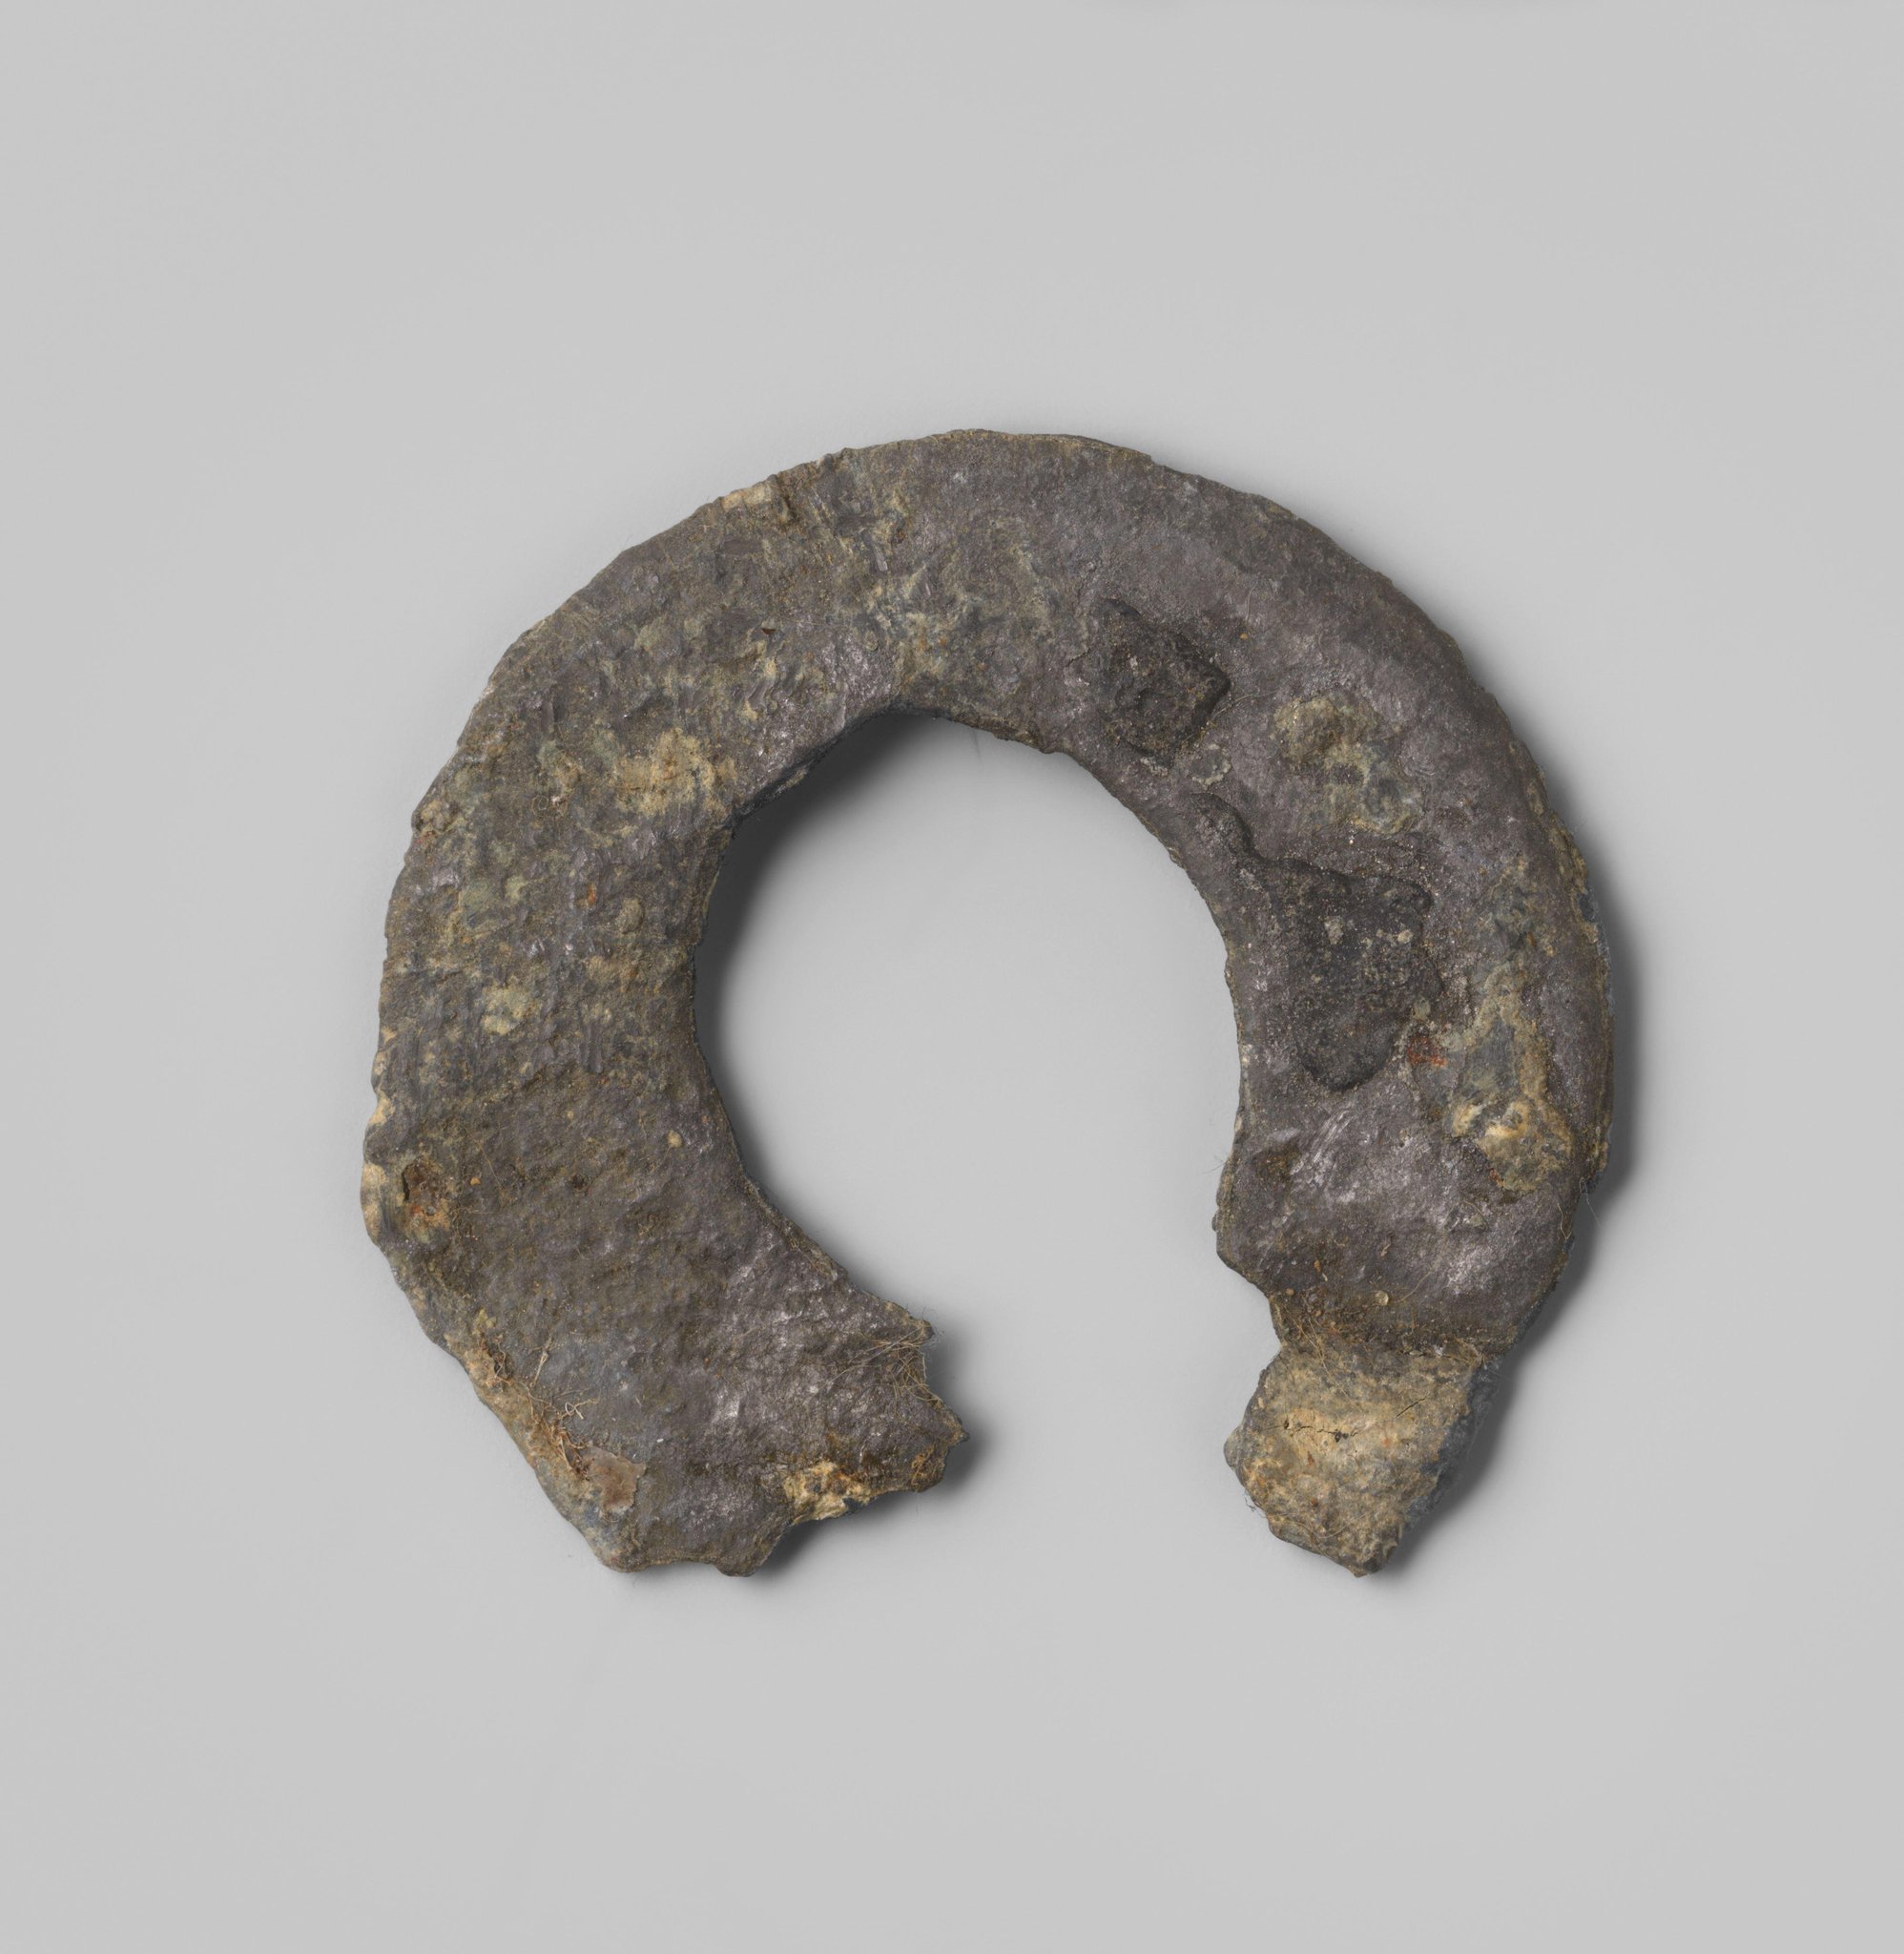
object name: lakenloodje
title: Fragment lakenloodje uit het wrak van de Oost-Indiëvaarder Hollandia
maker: Anonymous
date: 1700-1743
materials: lead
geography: netherlands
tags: verenigde oostindische compagnie, hollandia (schip), annet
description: Cloth seal; fragm, circular disc, eroded, inscription illegible.